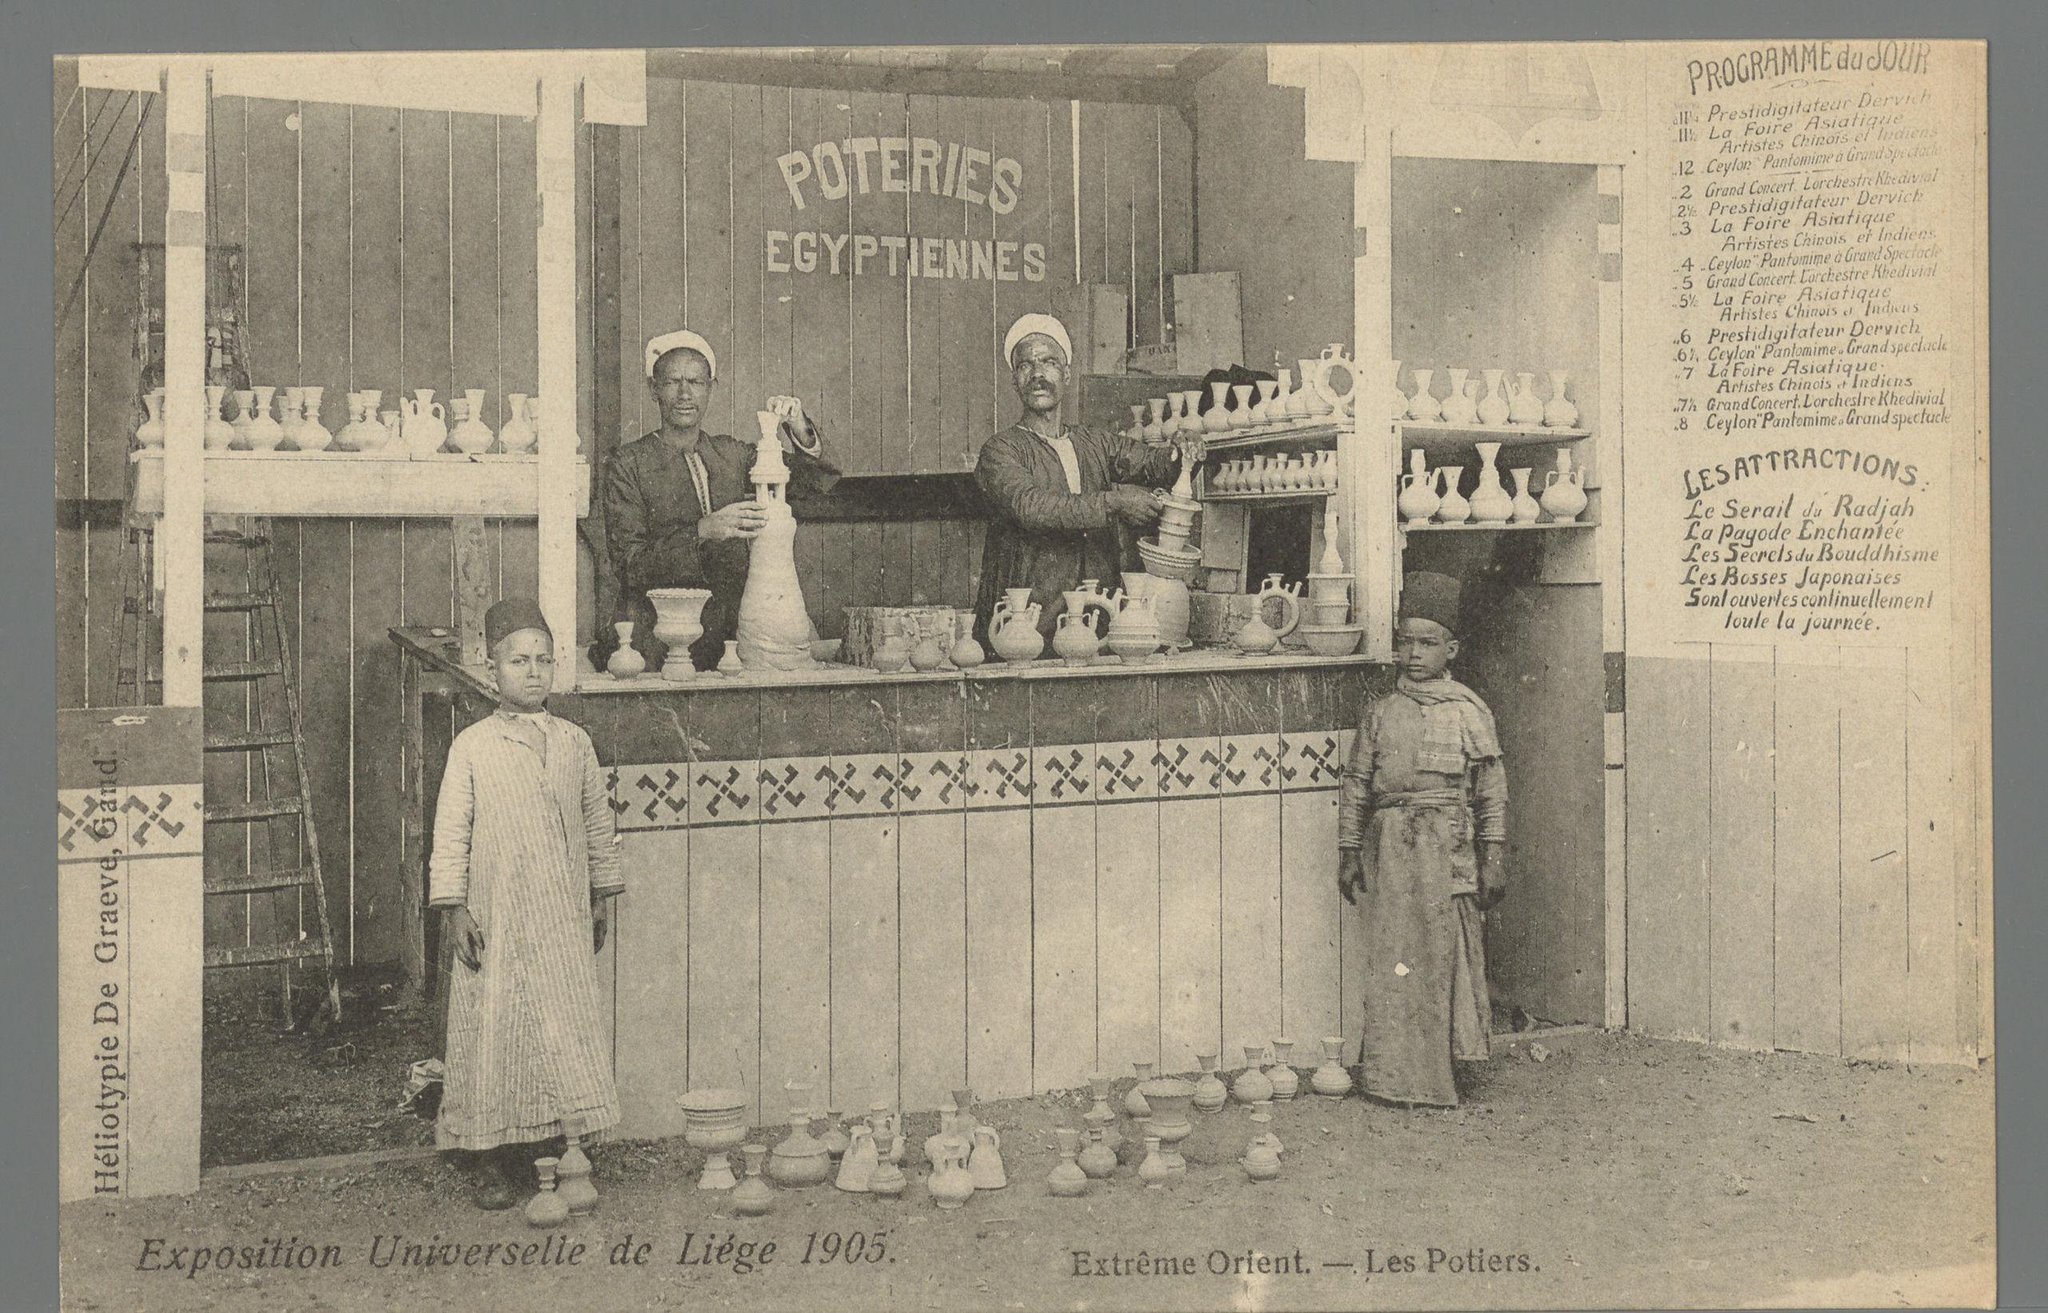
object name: photomechanical print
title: Exposition Universelle de Liège 1905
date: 1905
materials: cardboard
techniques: photograph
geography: liège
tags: world fair, world exhibition, stall, booth (~ market), handicrafts ~ clay, sand, chalk, liège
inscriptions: date